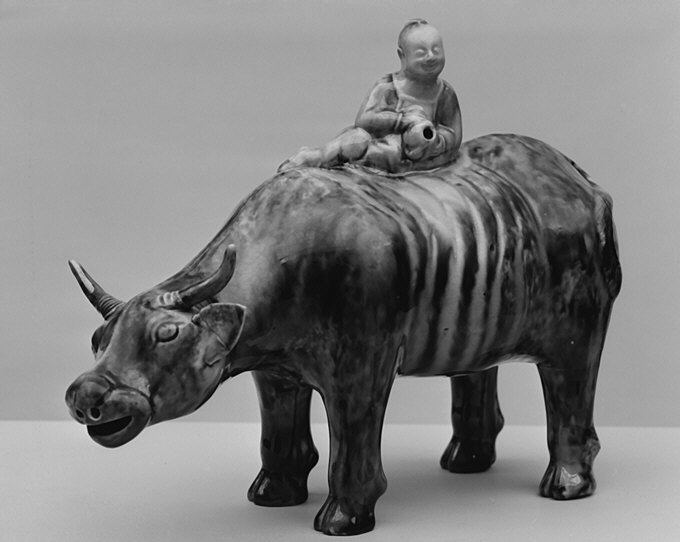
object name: figure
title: Water buffalo with boy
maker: whieldon type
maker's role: maker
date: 1750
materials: shell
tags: boys,buffalos